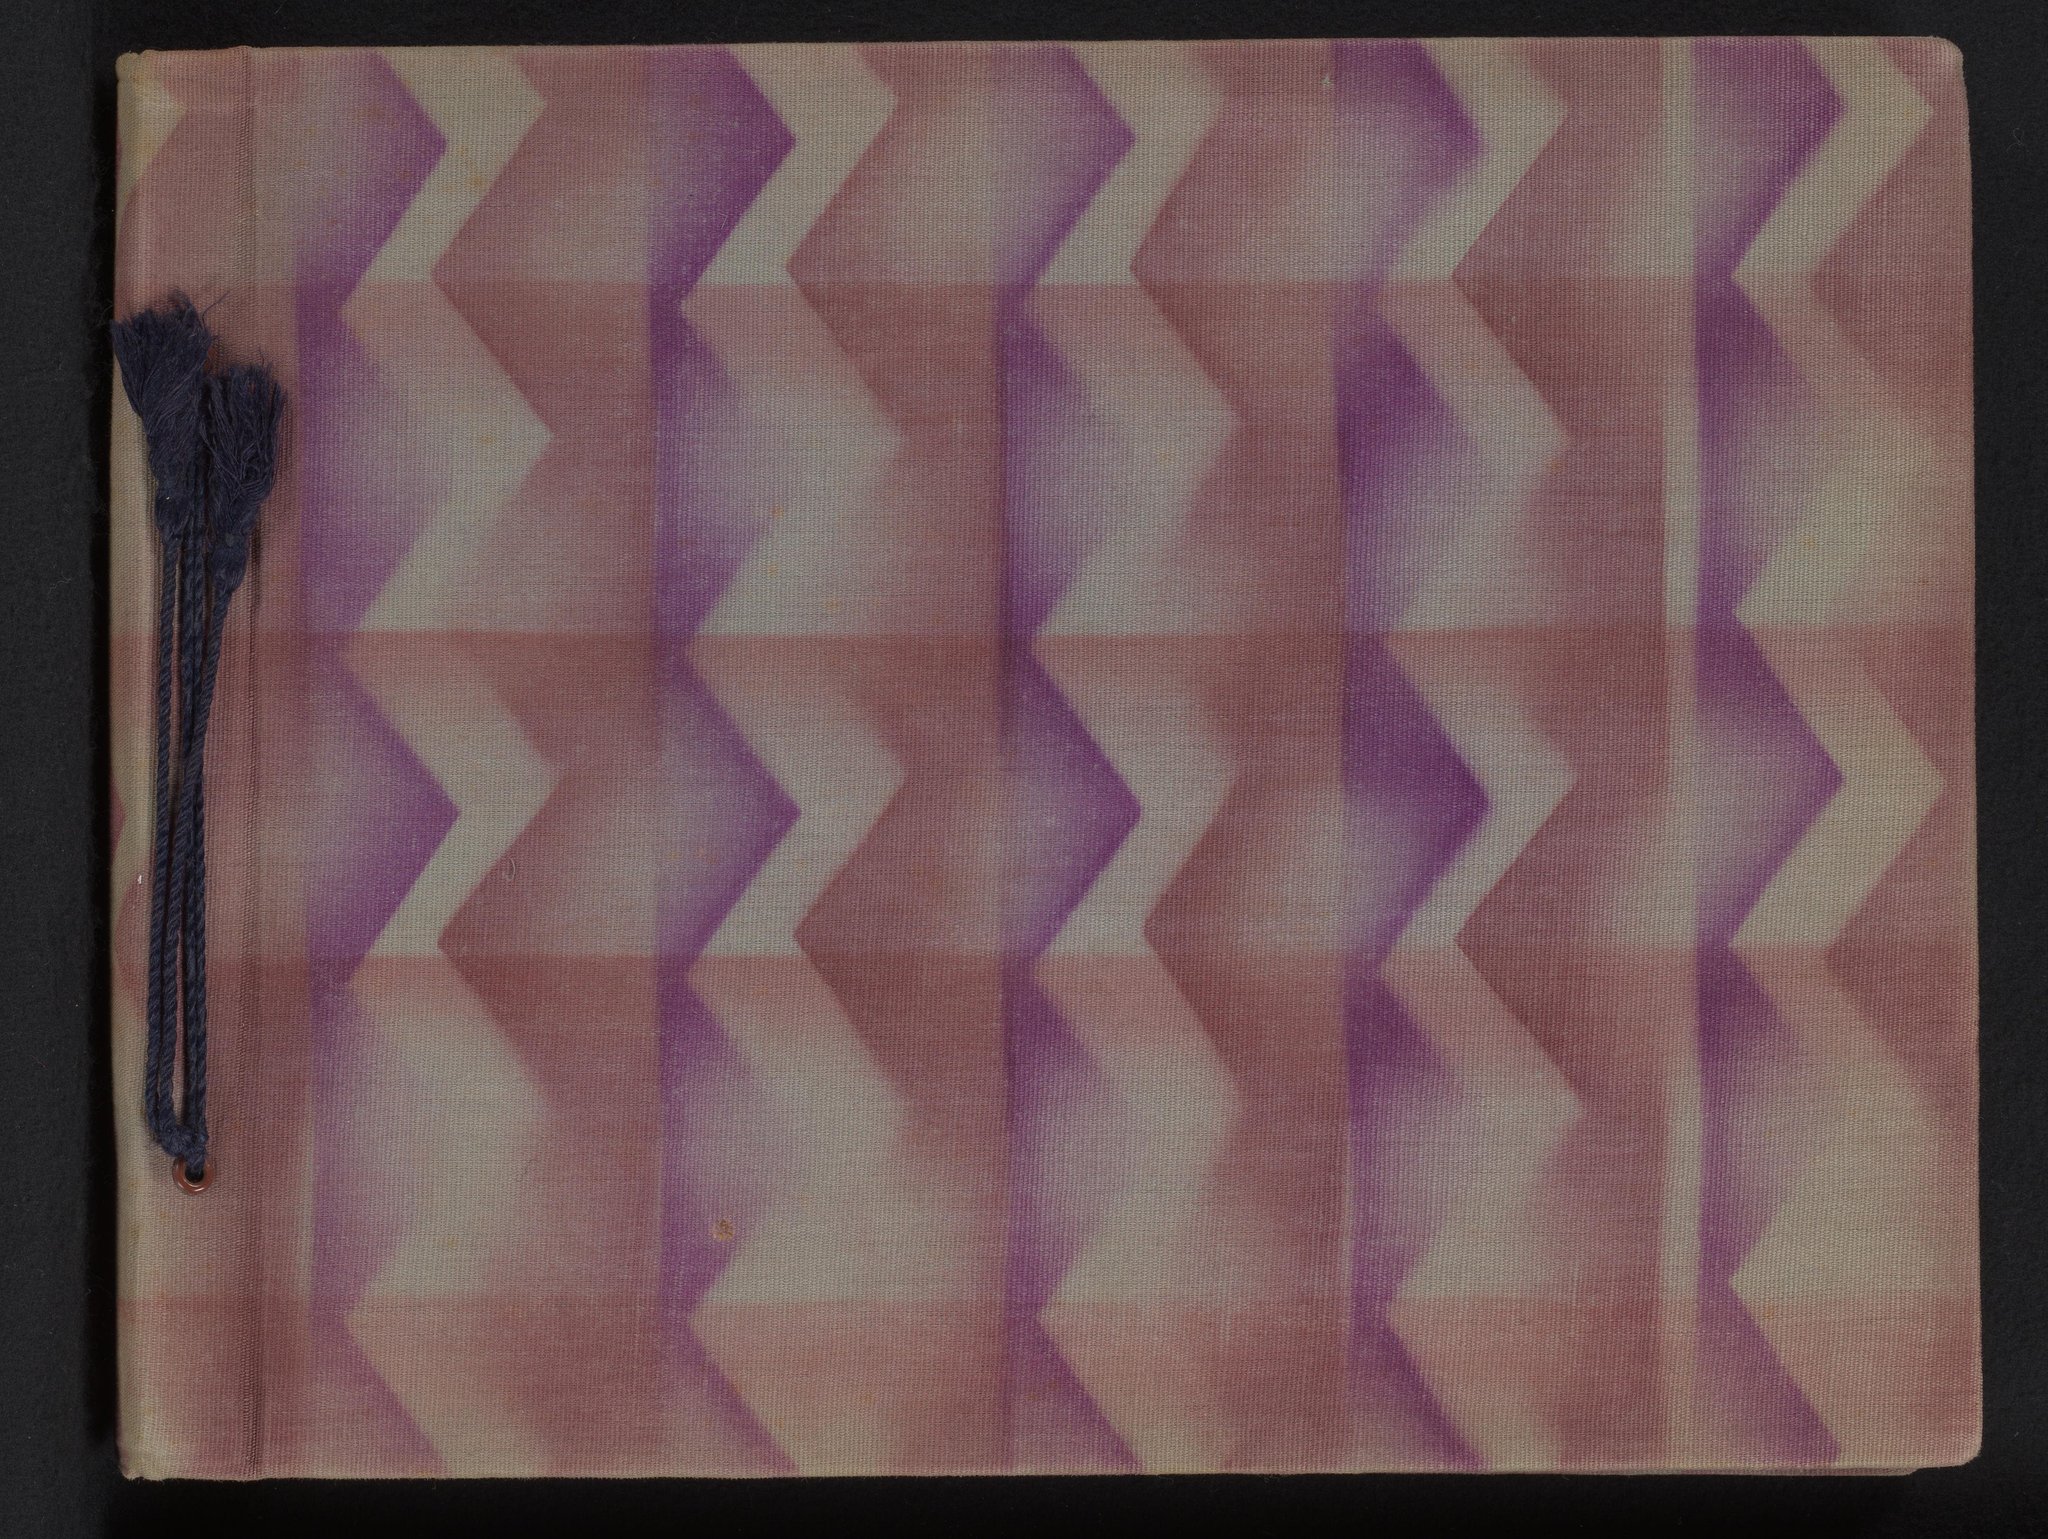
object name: photograph album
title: Fotoalbum met 85 foto's van bezienswaardigheden in Nederland en 140 persoonlijke foto's van Berti Hoppe en Herman Besselaar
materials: cardboard, linen, paper, photographic support, fiber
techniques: gelatin silver print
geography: netherlands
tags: herman besselaar, berti hoppe, dune coast, landscapes, historical persons - bb - woman, historical persons, sea (seascape), anonymous historical persons portrayed in a group, in a group-portrait, netherlands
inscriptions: company name: ‘REISA’, retailer's mark: ‘REISA ALBUM/ mit ges. gesch. Falzrücken/ (...)’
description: Fotoalbum 48 pagina's met in totaal 225 foto's, bestaand uit 85 gestandaardiseerde opnamen van (architectonische) bezienswaardigheden in verschillende steden in Nederland en 140 persoonlijke foto's van Berti Hoppe en Herman Besselaar, hun omgeving en hun kennissen. Onderdeel van vijf albums van de Besselaars.